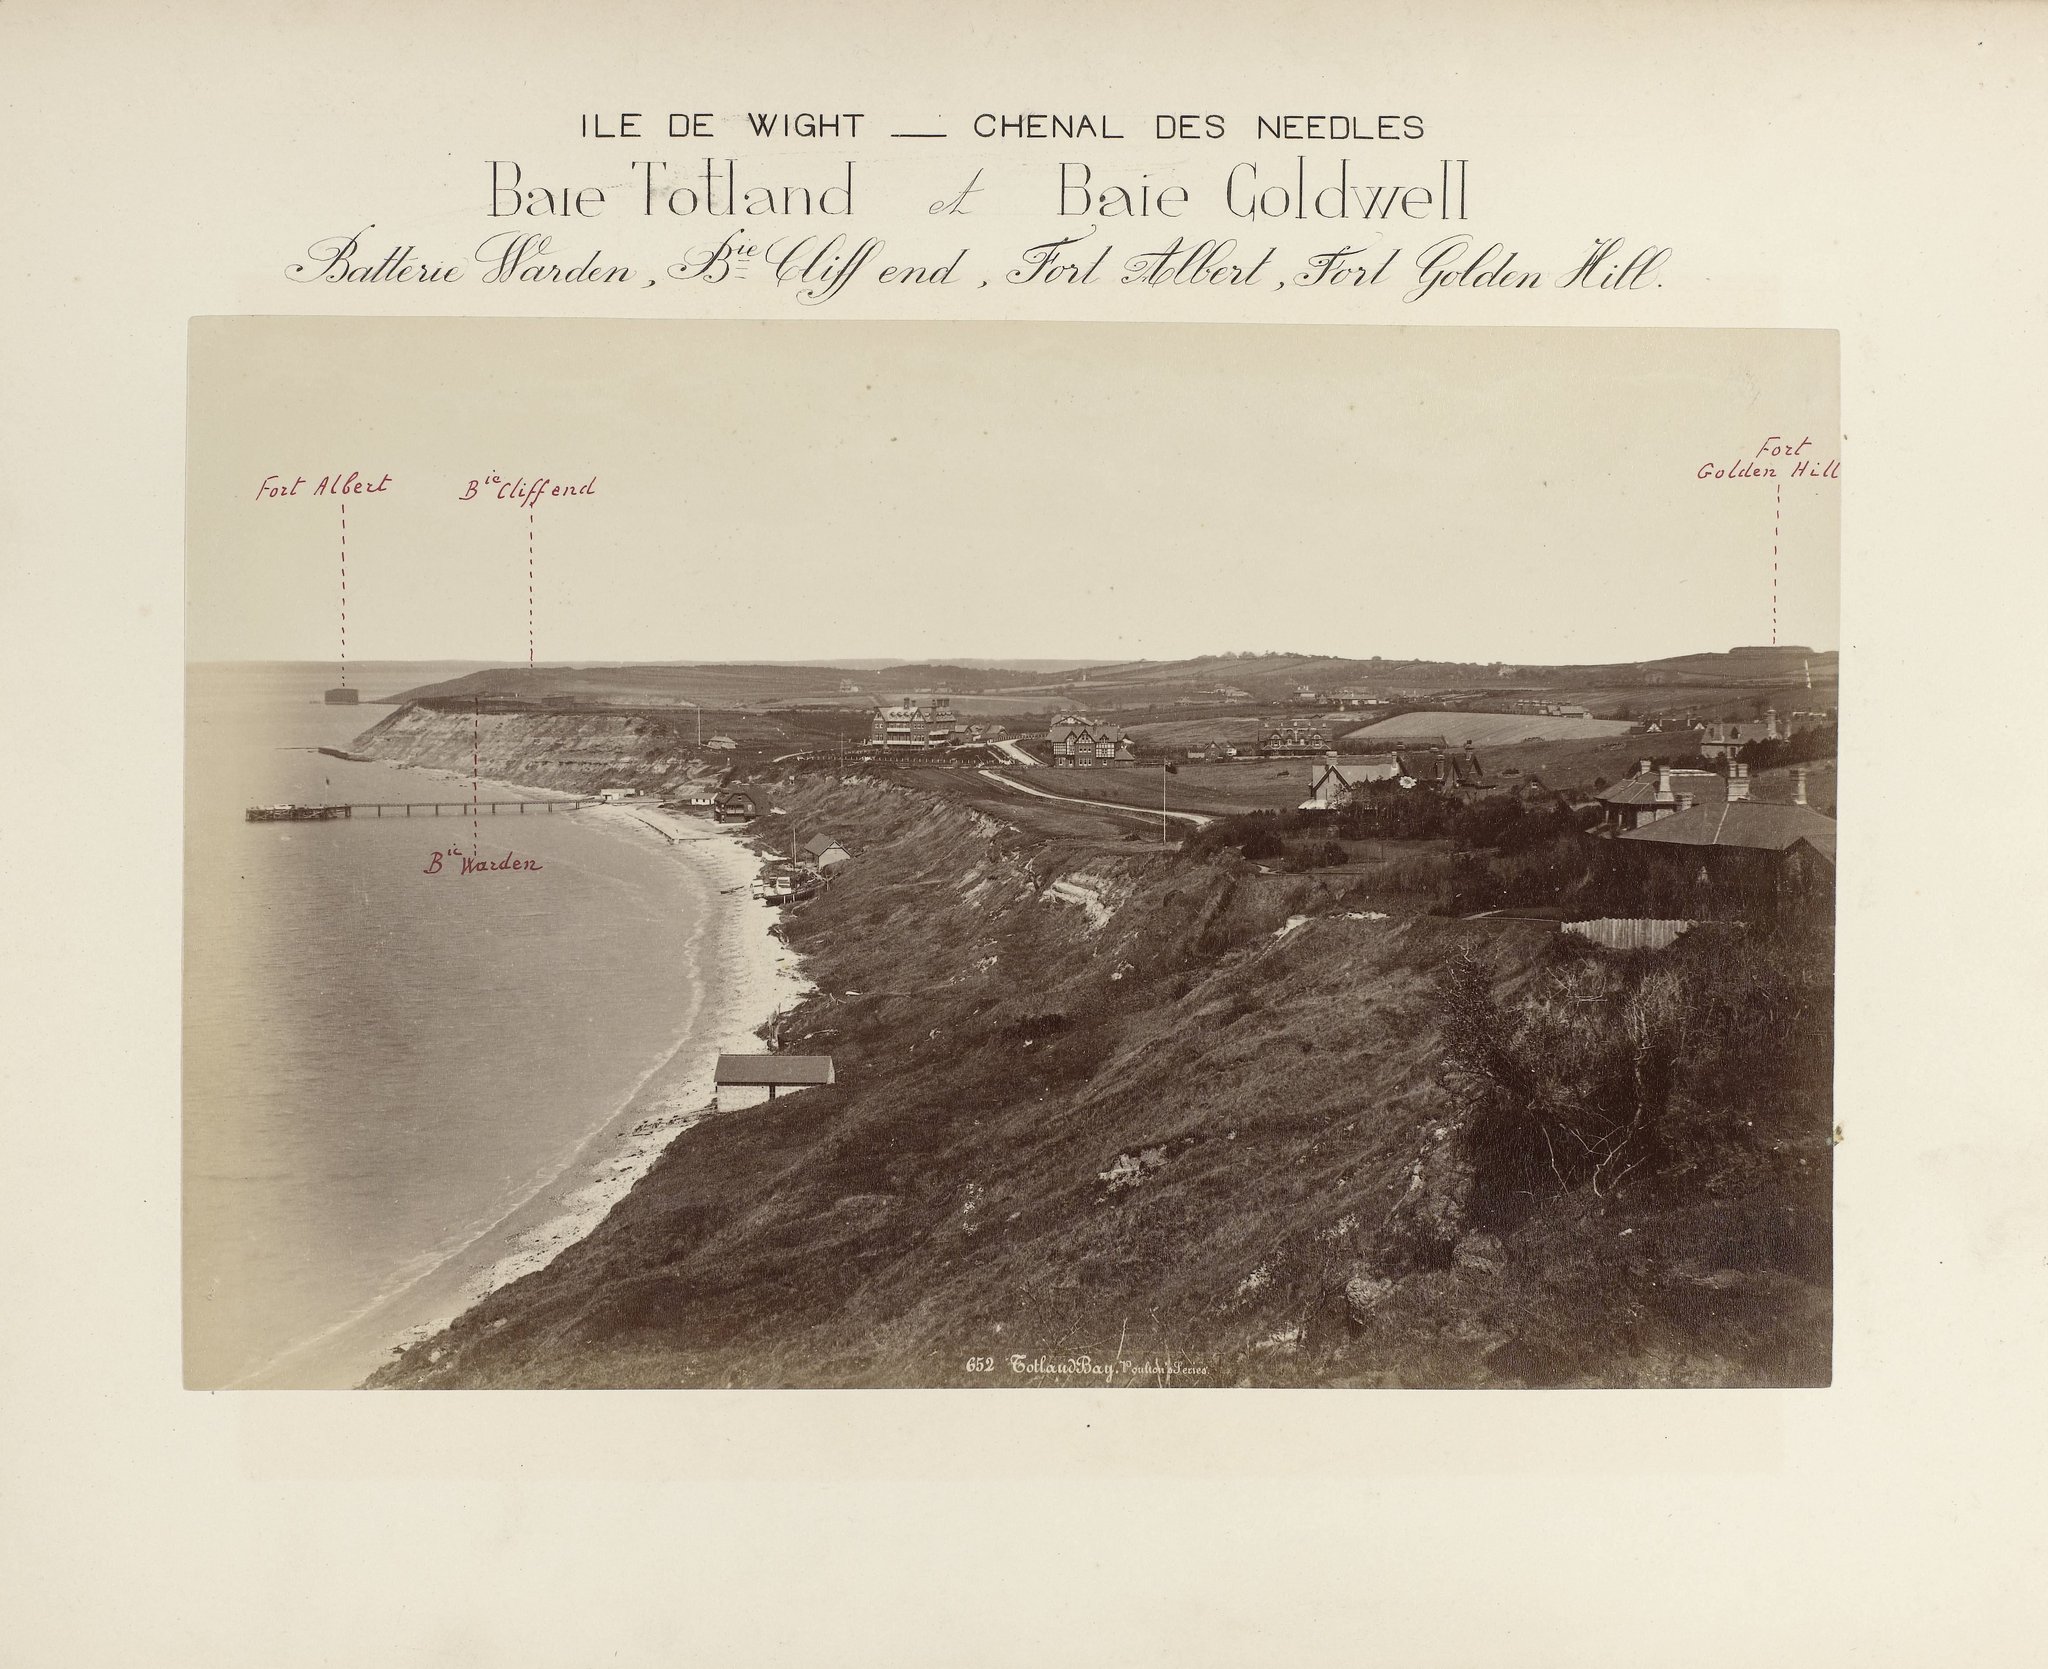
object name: photograph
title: Gezicht op Totland Bay en Coldwell Bay, Isle of Wight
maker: poulton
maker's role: fotograaf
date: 1891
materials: cardboard, paper, photographic support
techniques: albumen print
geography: great britain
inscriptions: inscription: ‘ILE DE WIGHT / CHENAL DES NEEDLES / Baie Totland et Baie Coldwell / Batterie Warden, Bie Cliff end, Fort Albert, Fort Golden Hill.’, annotation: ‘Ft Albert // B[atter]ie Warden // B[atter]ie Cliff end // Fort / Golden Hill’, inscription: ‘652 Totland Bay, Poulton's Series’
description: Foto uit een album met 35 topografische foto's van Britse kustplaatsen, waarop in pen militaire verdedigingswerken zijn aangegeven door een Franse militair.